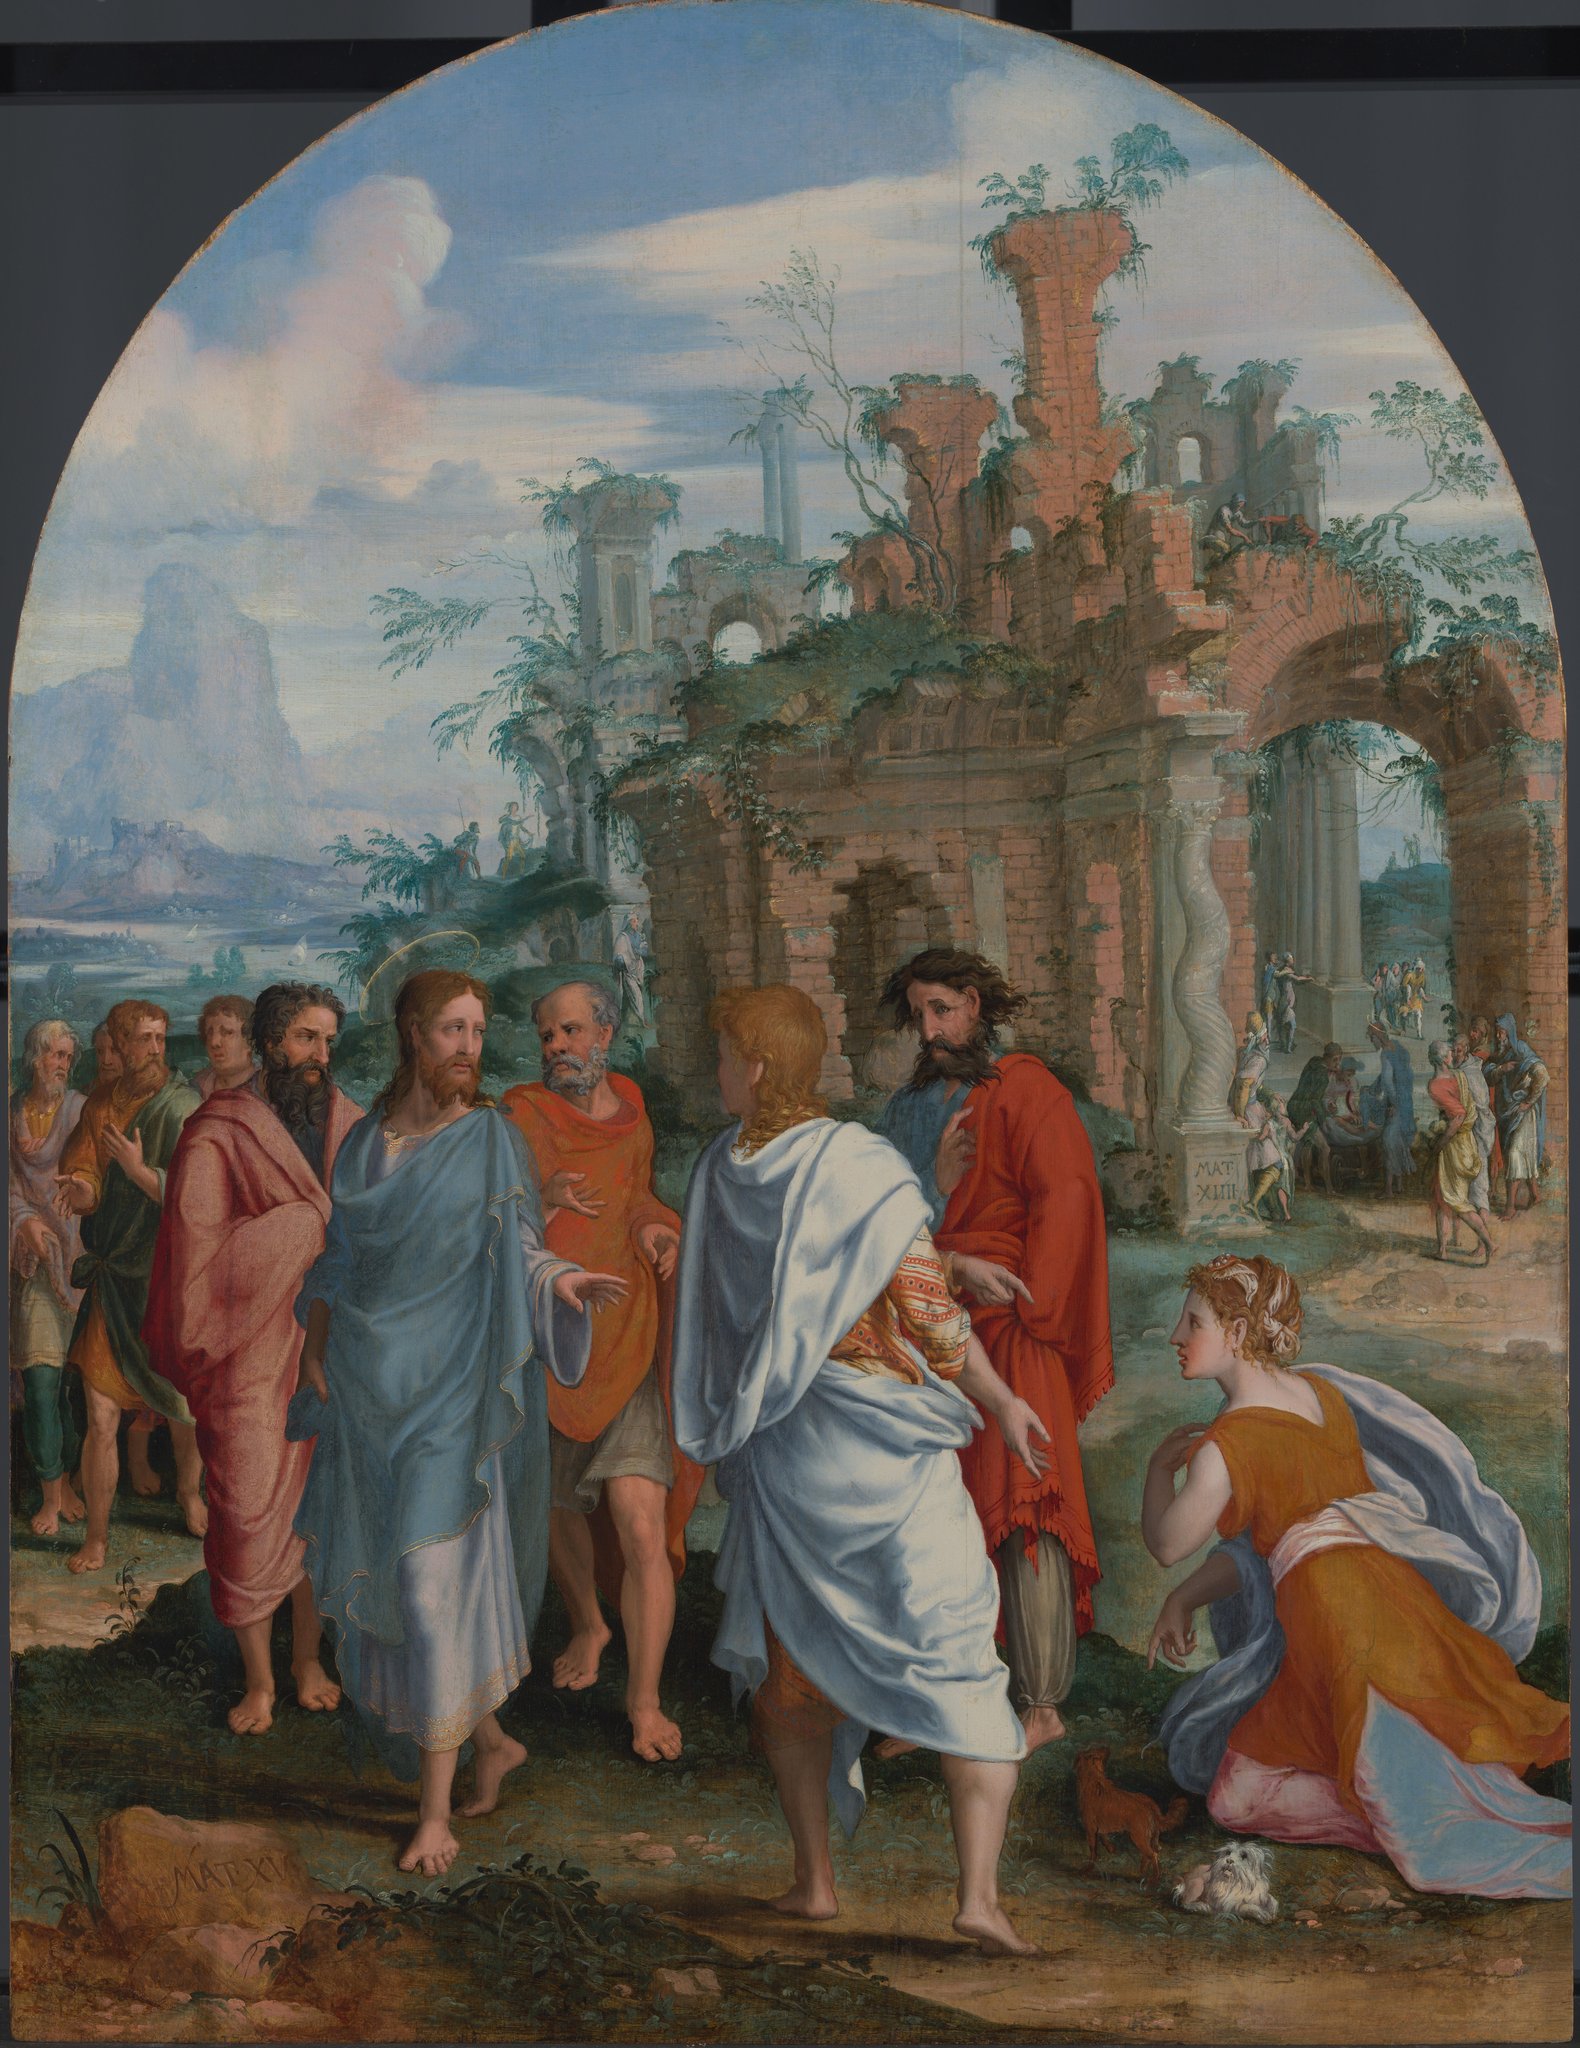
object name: painting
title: Jesus and the Canaanite Woman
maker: Anonymous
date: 1550-1555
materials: oil, paint, panel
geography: northern netherlands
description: Voor een weids landschap met prominente Romeinse ruïnen is Jezus onderweg met acht van zijn discipelen. Jezus is hier in gesprek met een Kanaänitische vrouw (Mat. 15:21-28). Op de achtergrond onder de grote boog heelt Jezus de zieken. (Mat. 14:14).